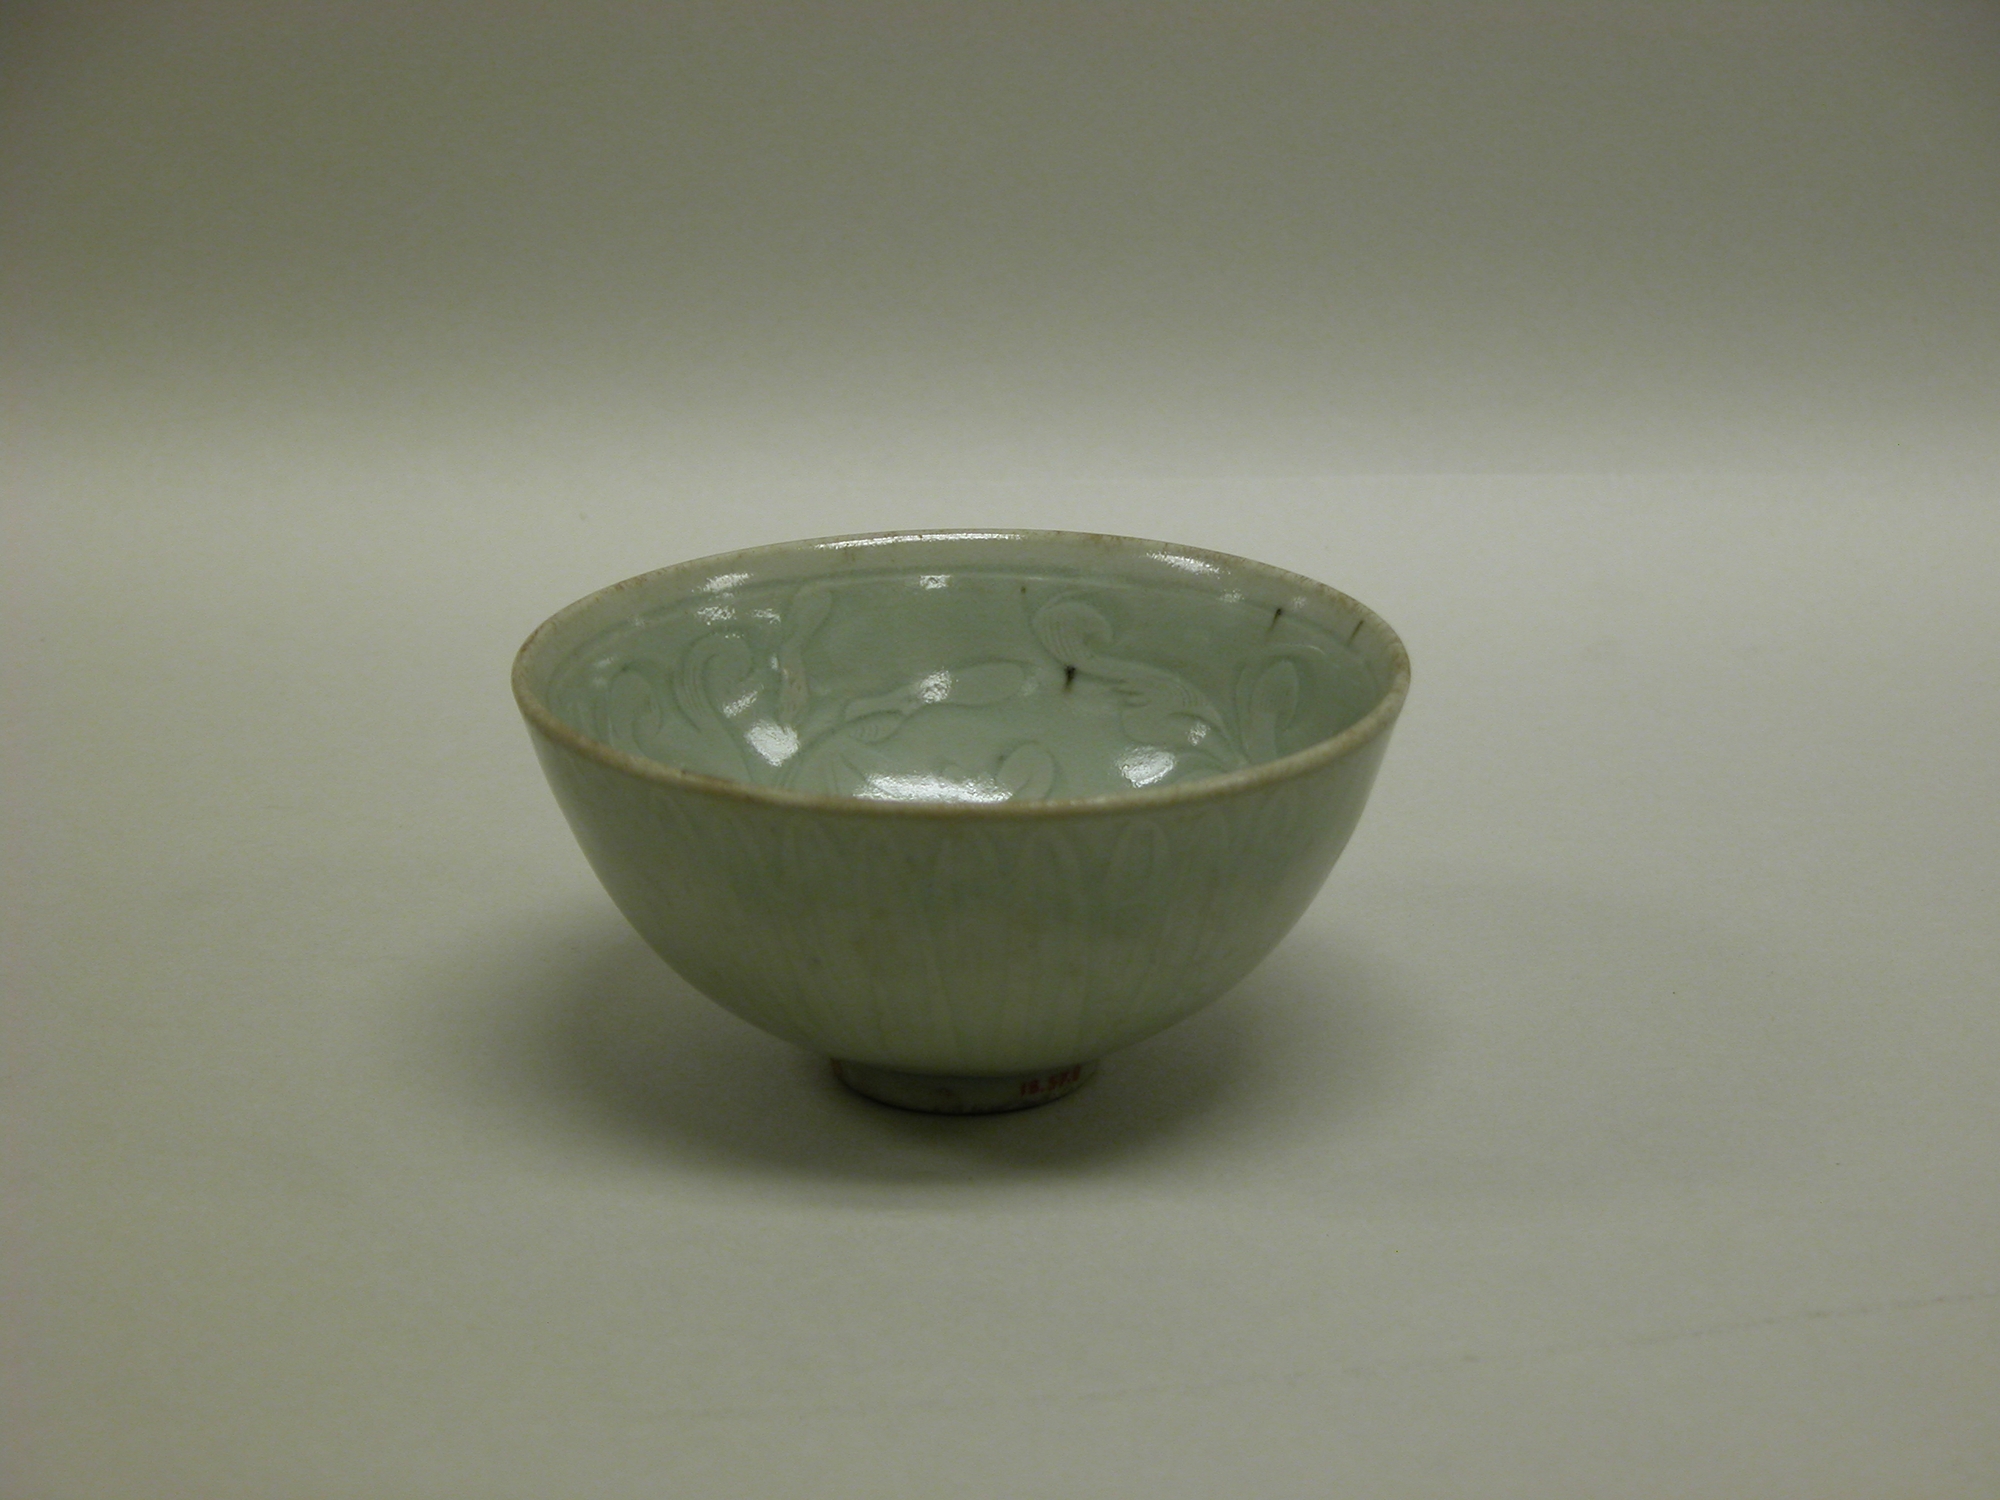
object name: bowl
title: Bowl with floral patterns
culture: chinese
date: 1301-1400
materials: ceramic glaze, glaze, stoneware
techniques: incising